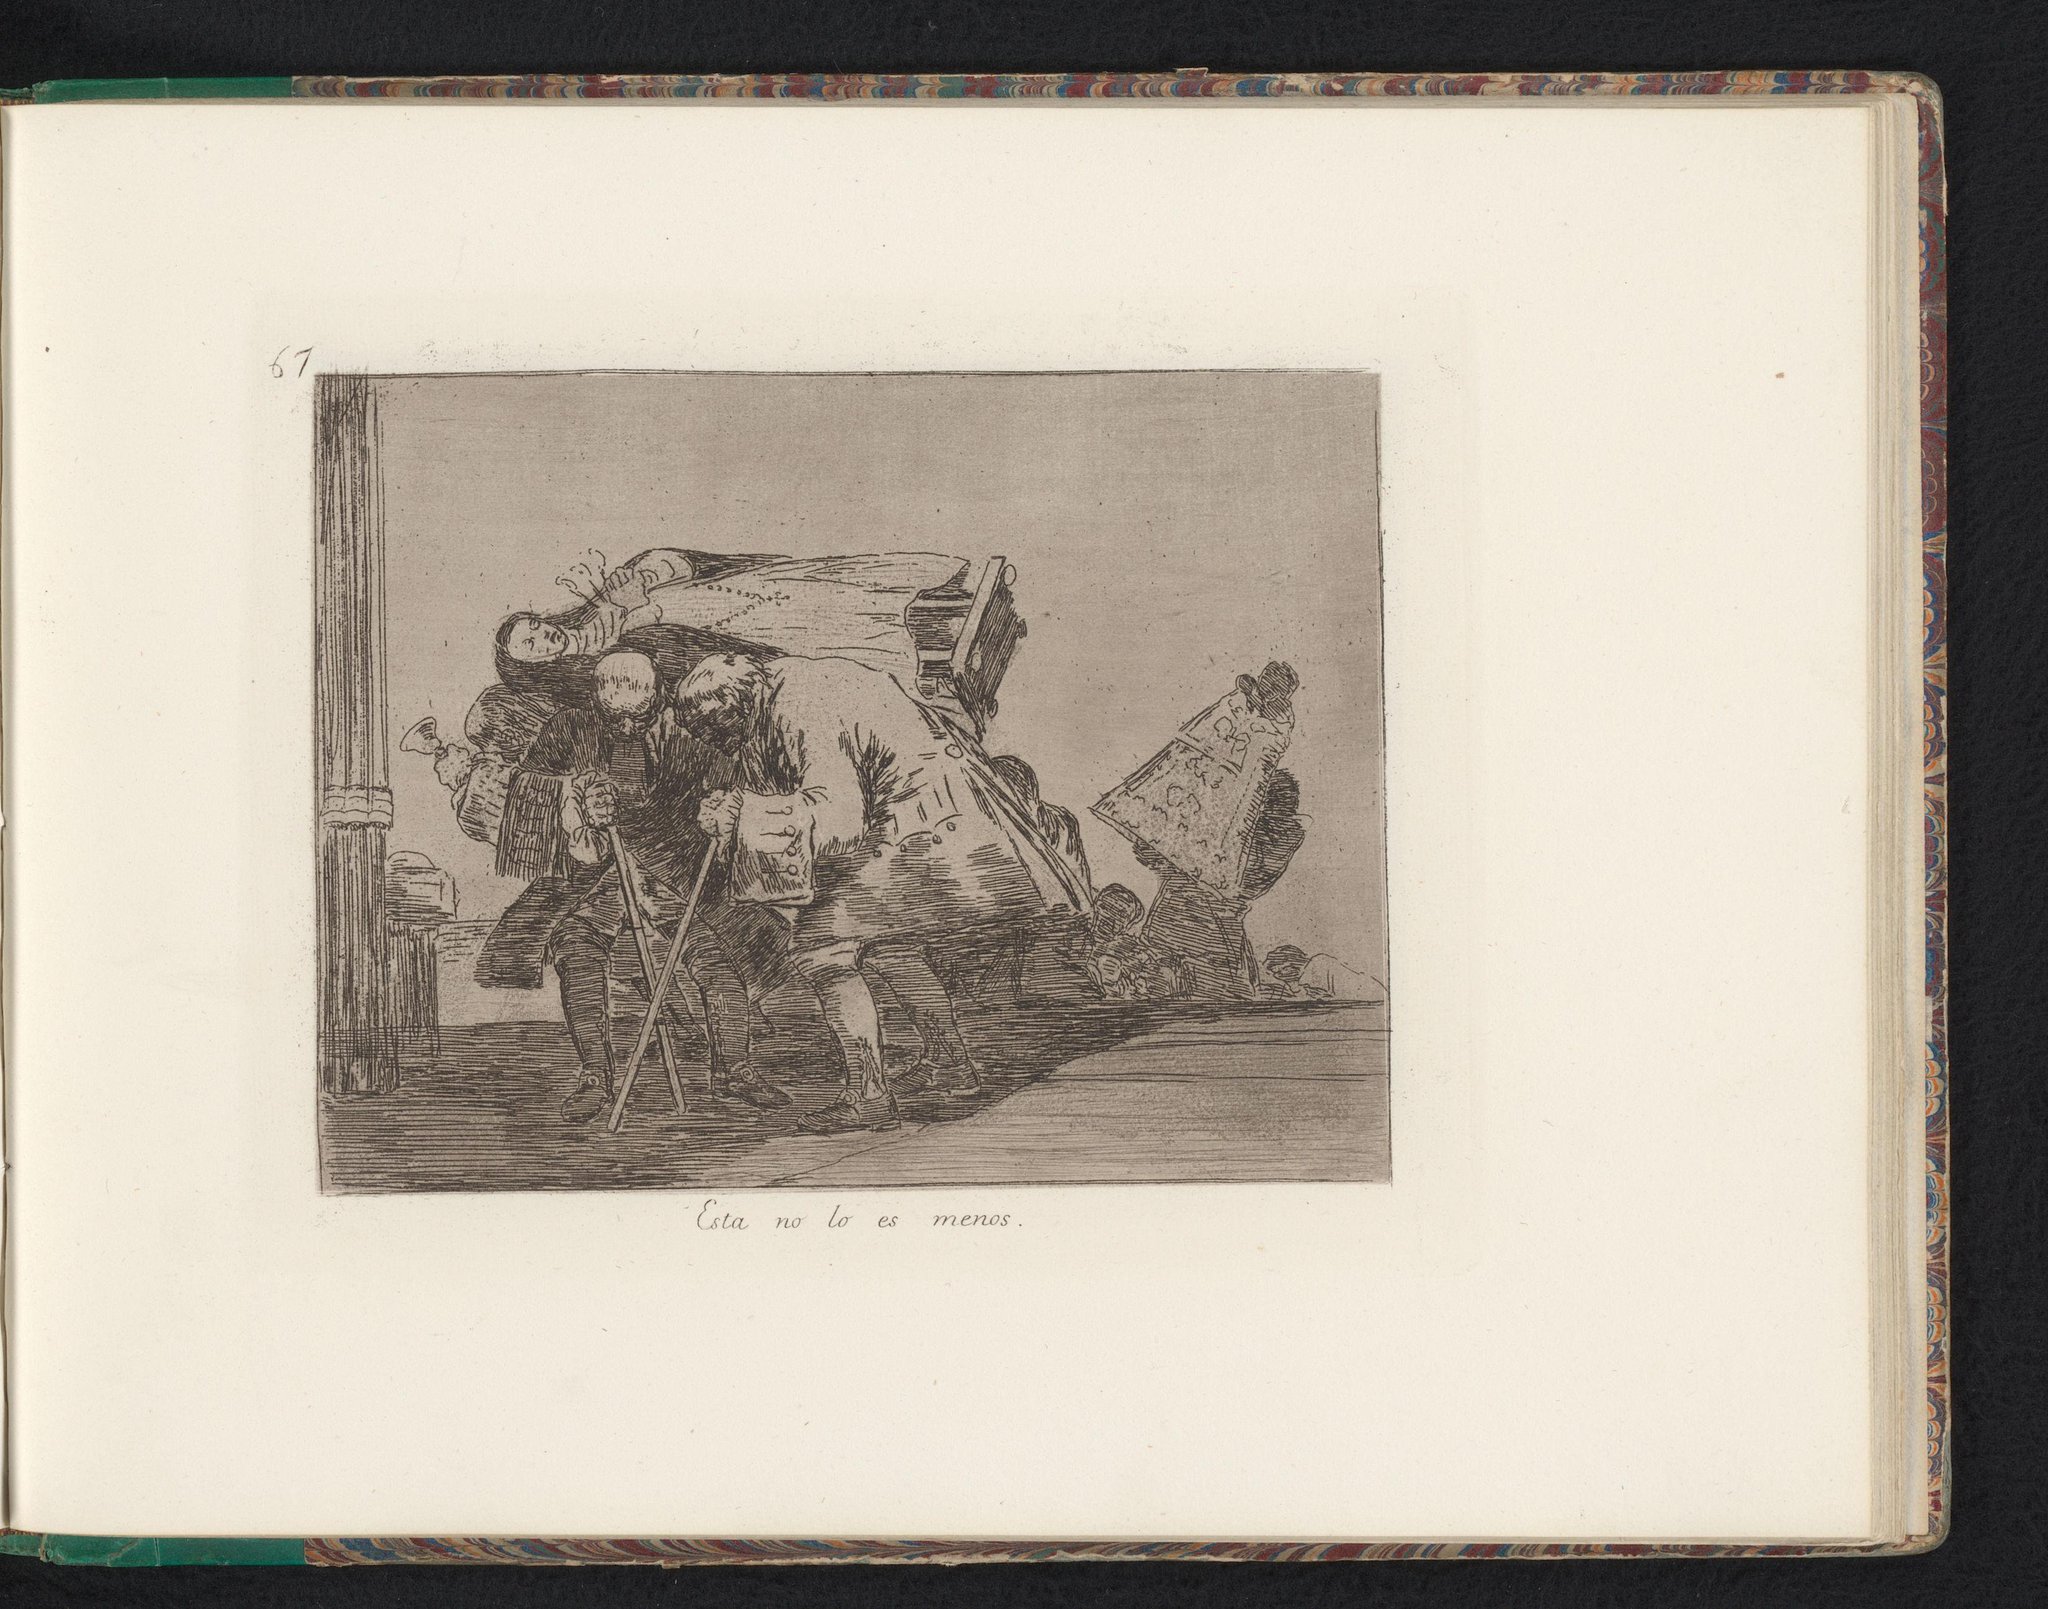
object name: album leaf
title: Gruwelen van de oorlog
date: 1810-1820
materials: paper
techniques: aquatint, drypoint, engraving, etching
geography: madrid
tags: veteran, funeral effigy, horrors of war, spain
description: Deze prent maakt deel uit van een album.